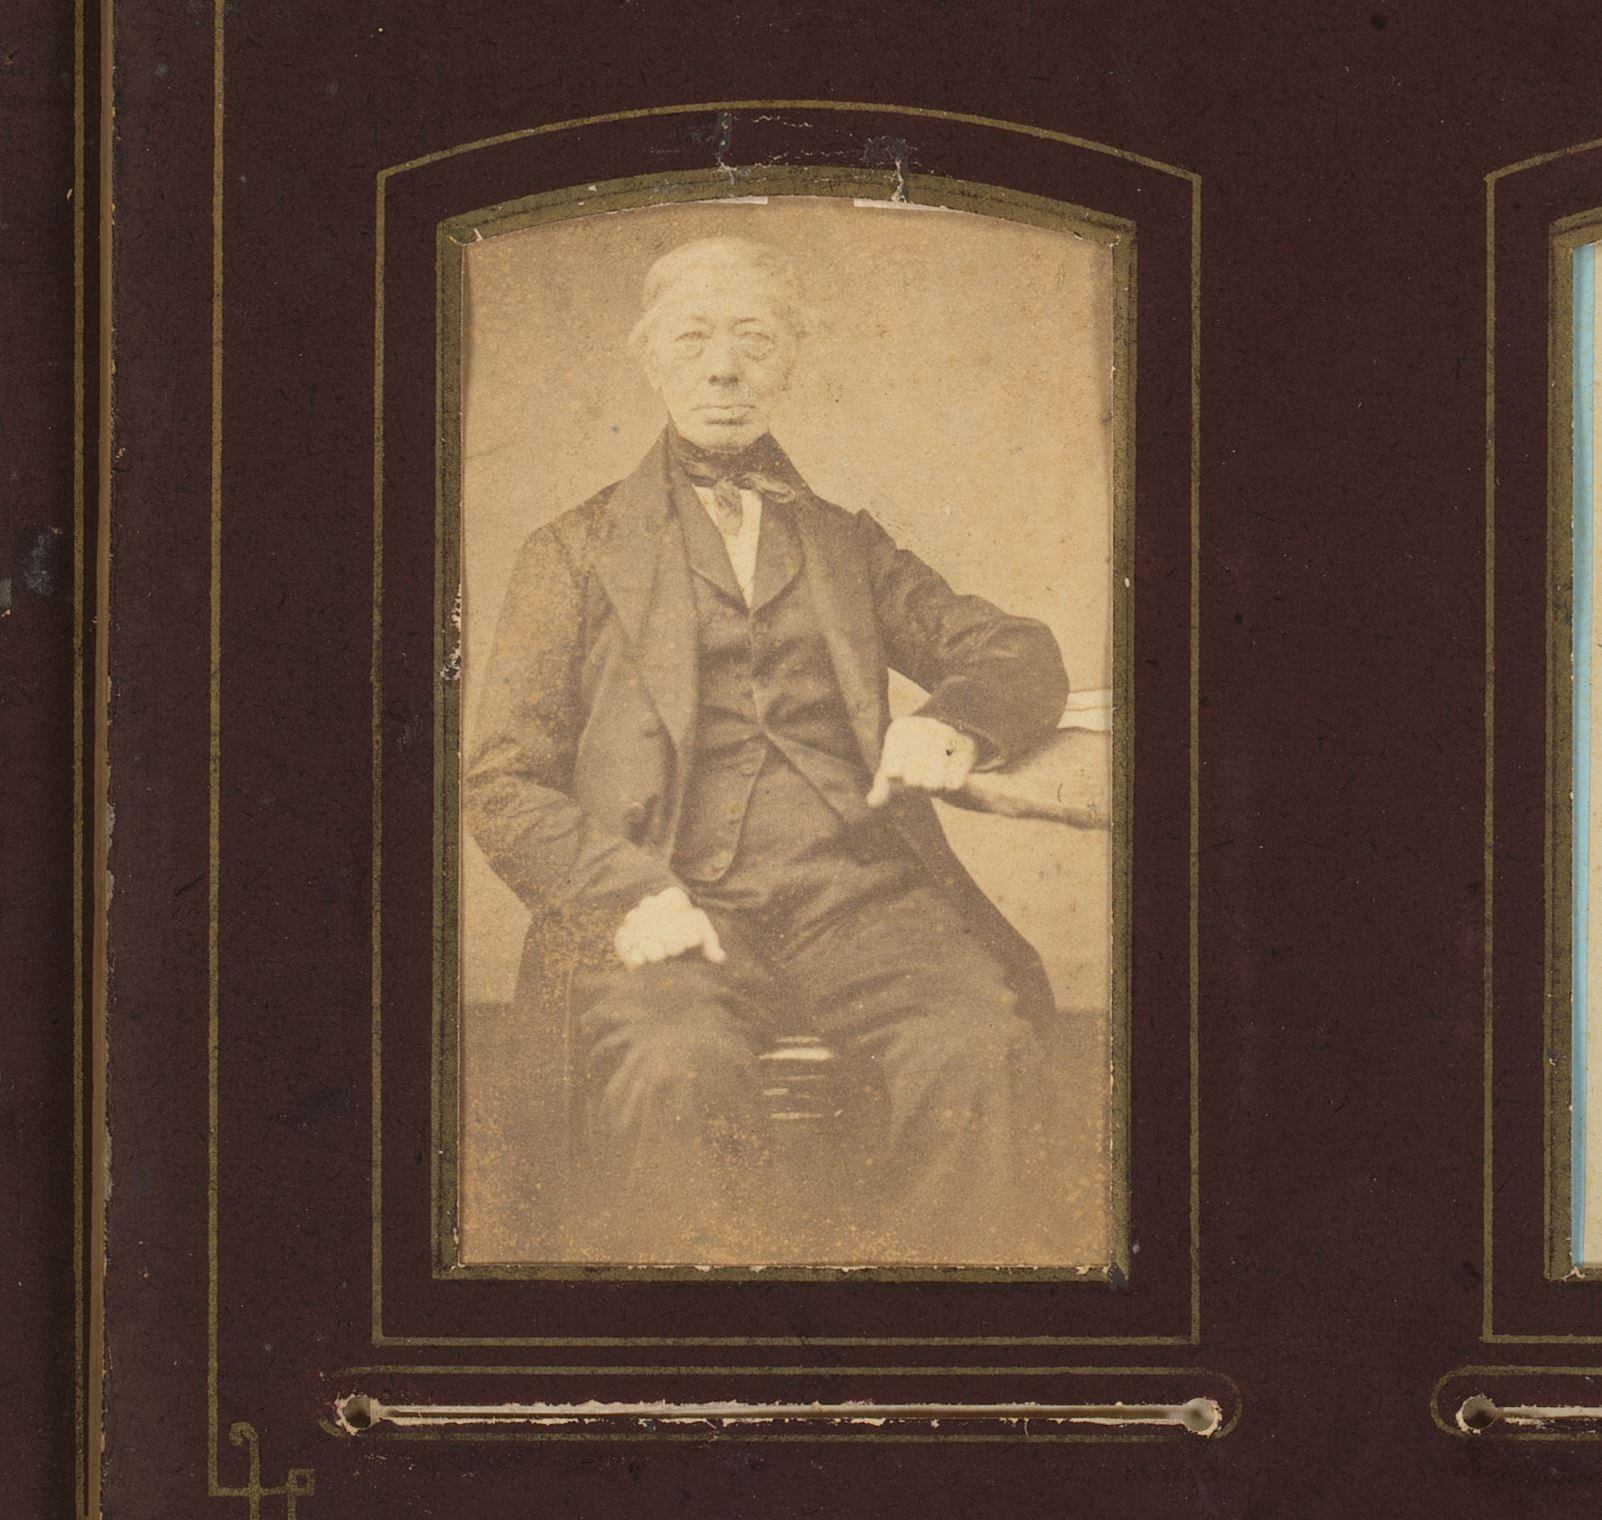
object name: photograph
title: Portret van een zittende man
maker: frederik caland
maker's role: fotograaf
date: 1850-1900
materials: cardboard, photographic support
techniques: albumen print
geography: dirksland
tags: historical persons, chair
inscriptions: inscription: ‘Fred k Caland./ FOTOGRAFIST/ DIRKSLAND.’